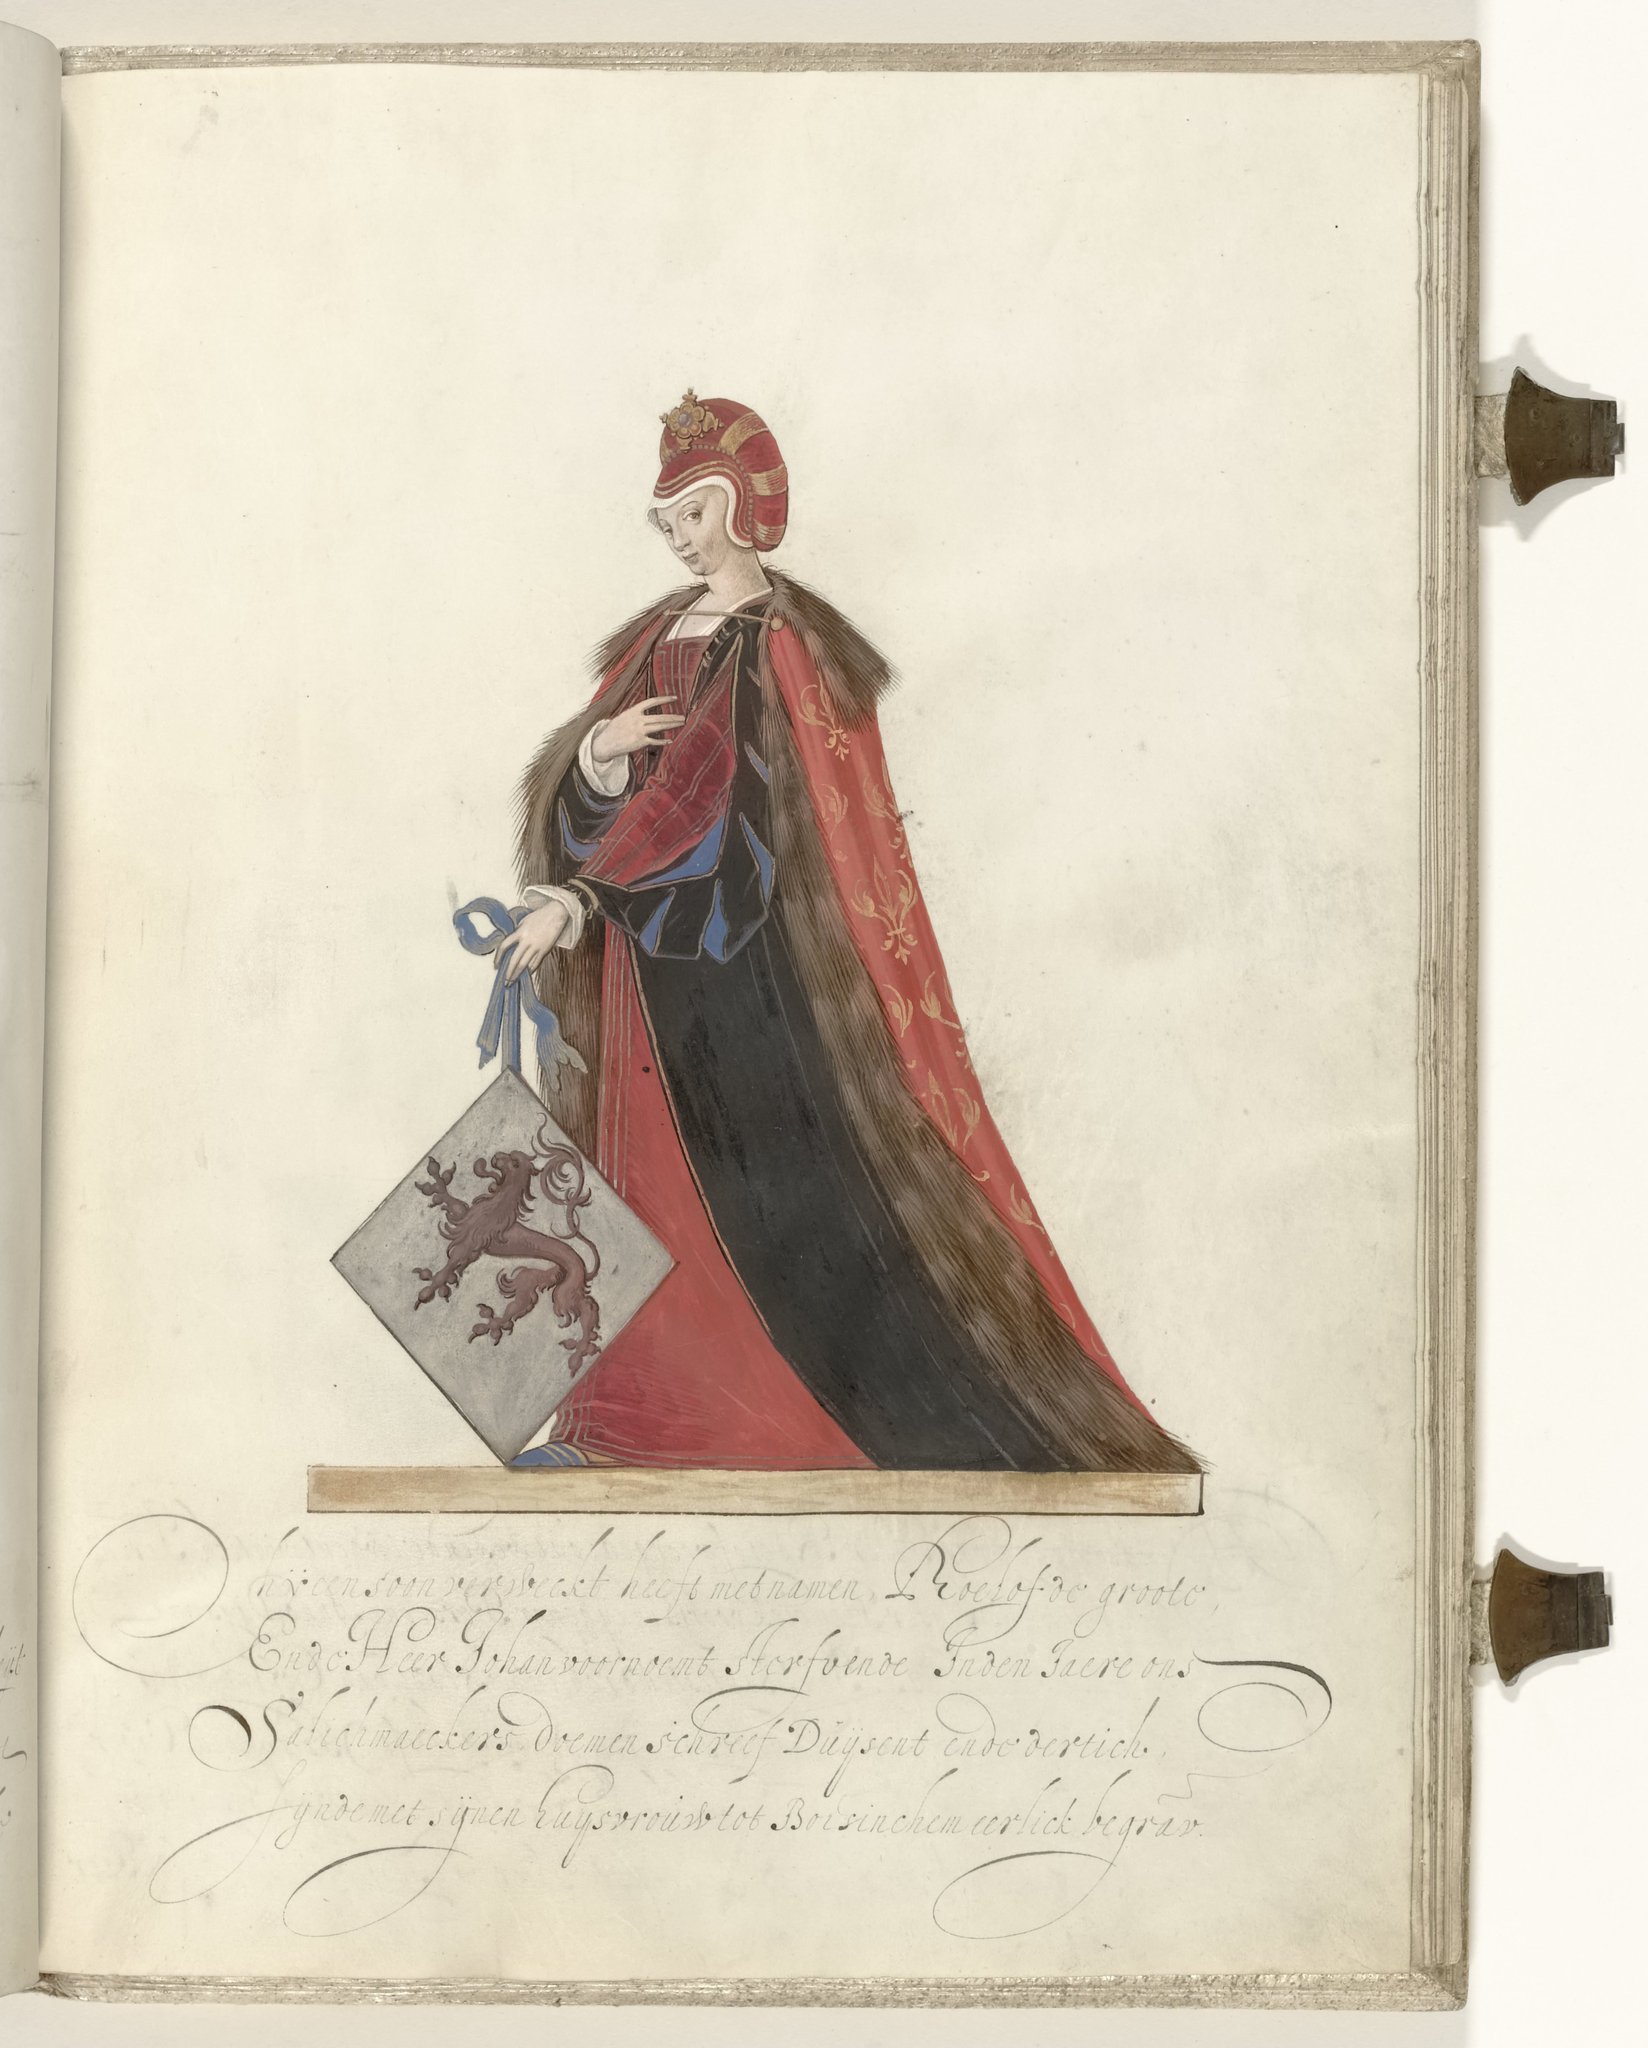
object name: drawing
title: Gravin van Beusichem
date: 1590-1593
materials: paint, gouache, ink, parchment, watercolor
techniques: writing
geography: northern netherlands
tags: culemborg, heren en graven van, heren van beusichem, culemborg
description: Gravin van Beusichem. Echtgenote van graaf Hendrik van Beusichem. Dochter van Simon, eerste heer van Teylingen. Overleden in 1120. Staande ten voeten uit, in de linkerhand het wapen van Teylingen. Onderdeel van een geïllustreerd handschrift met de genealogie van de heren en graven van Culemborg.